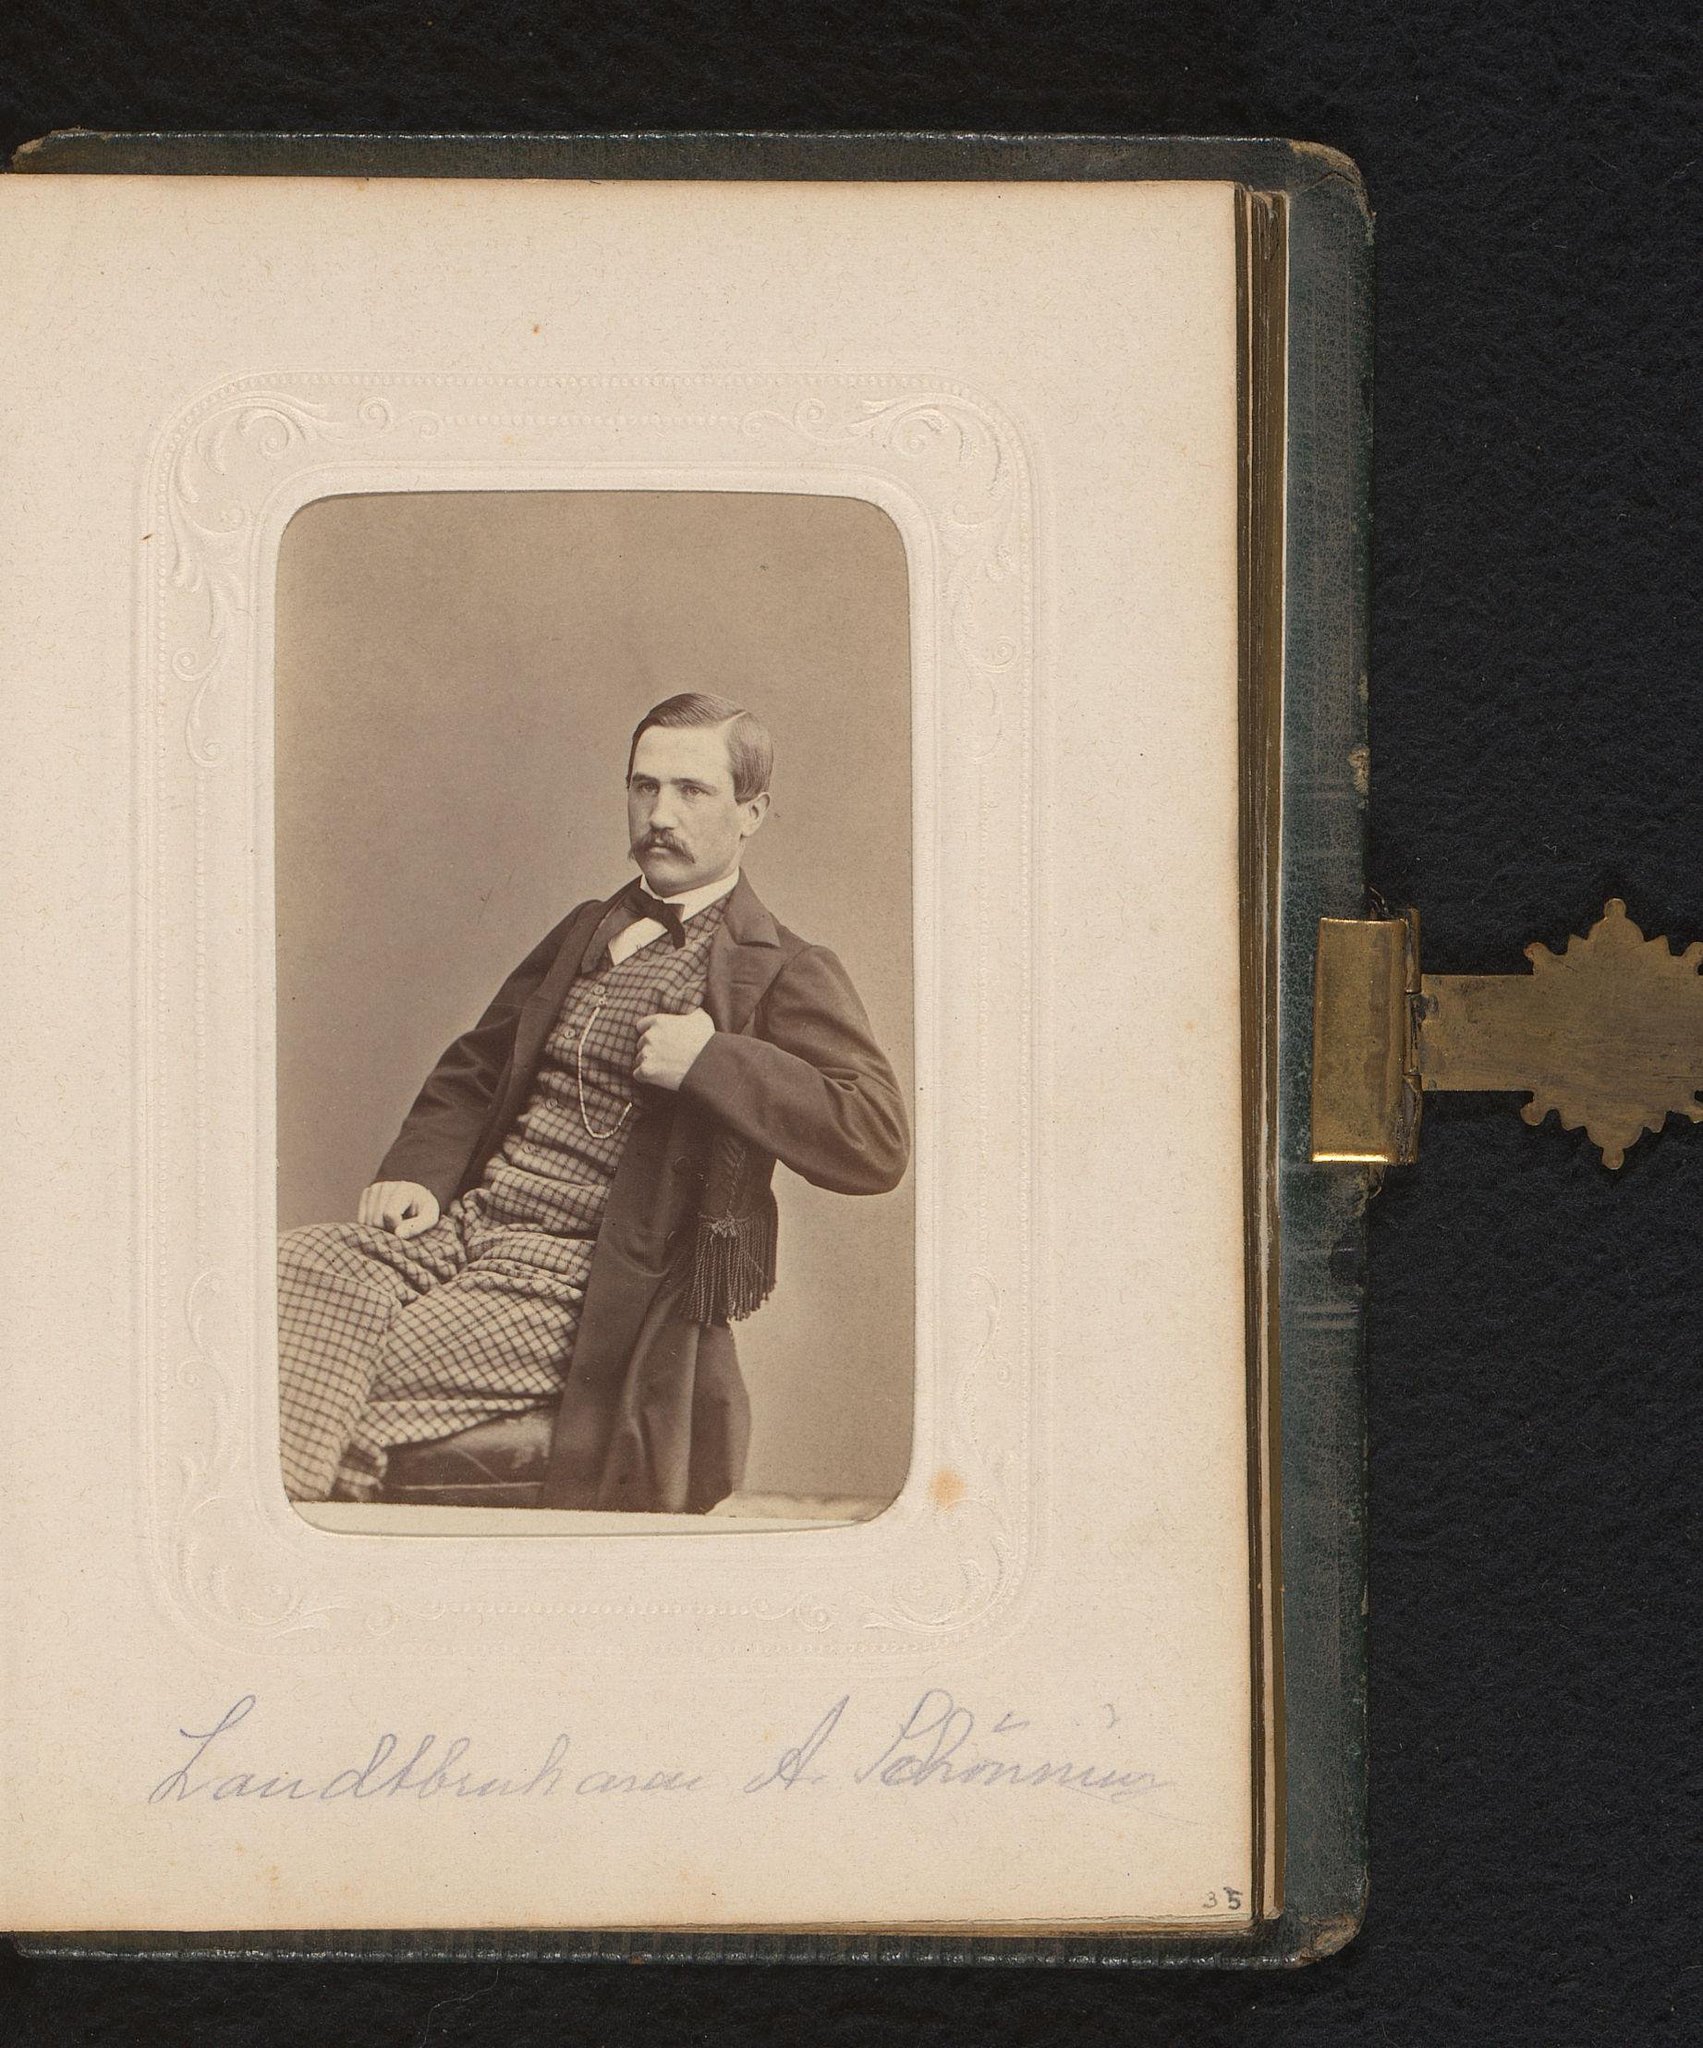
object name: photograph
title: Portret van een zittende man, aangeduid als Axel Schönning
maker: henri osti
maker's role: fotograaf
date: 1860-1900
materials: cardboard, photographic support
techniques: albumen print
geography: stockholm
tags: sitting figure, historical persons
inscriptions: inscription: ‘H. OSTIs/ Fotografi-Atelier/ STOCKHOLM/ No. 28 A, Regeringsgatan No. 28, A/ samma ingang som/ SVENSKA INDUSTRI-MAGASINET.’, annotation: ‘f.d. Land[...]rukaren/ Axel Schönning/ No[..]land’